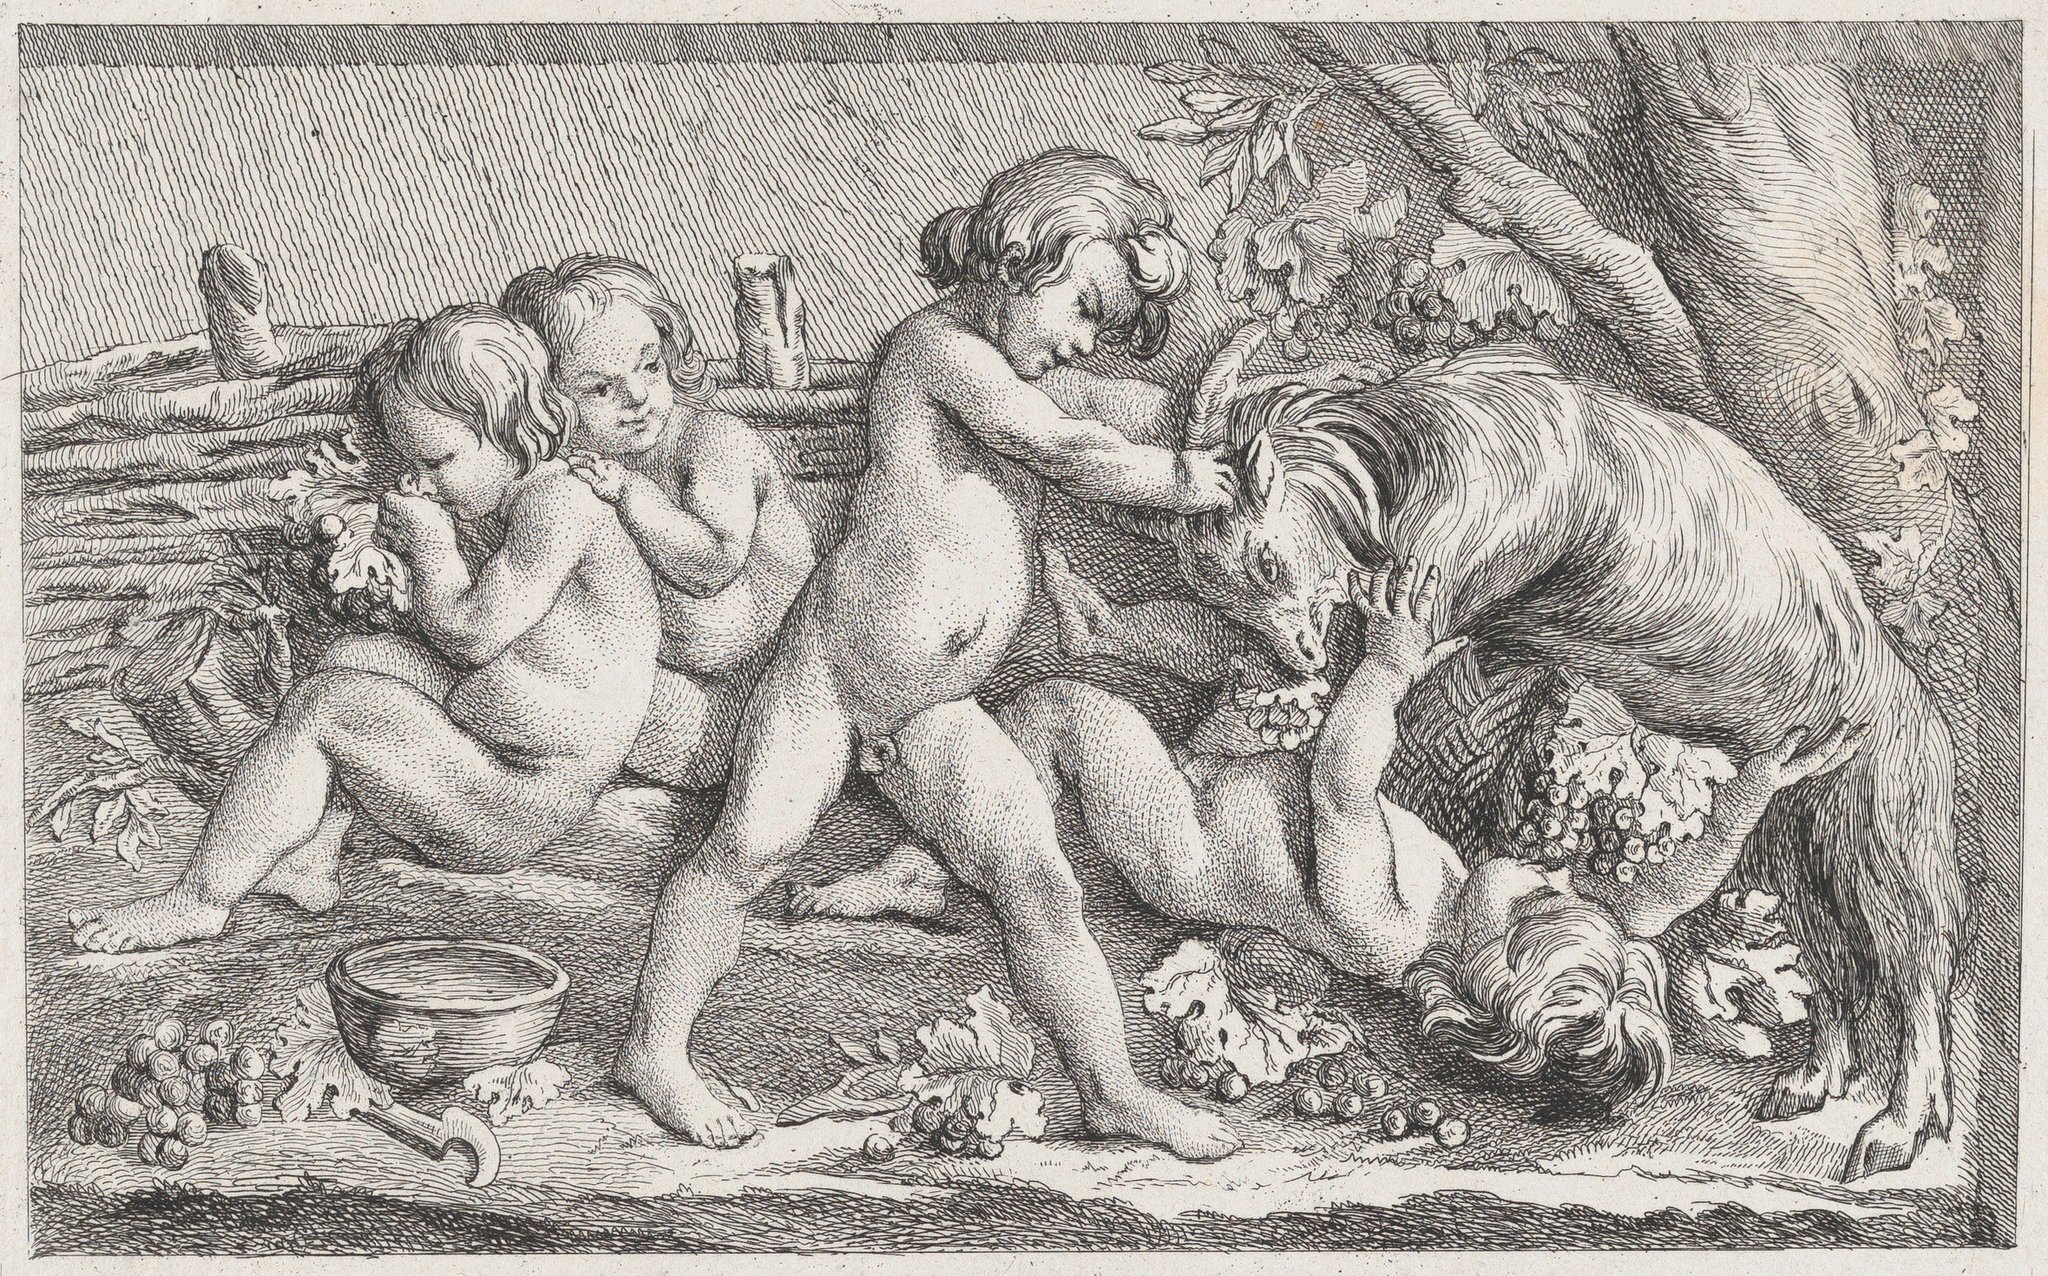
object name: print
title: Nude children eating grapes and playing with a goat; an allegory of Fall, after a bas-relief on the Fontaine des Quatre-Saisons (Paris)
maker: Anonymous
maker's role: artist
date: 1745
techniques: etching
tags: grapes,children,playing,goats